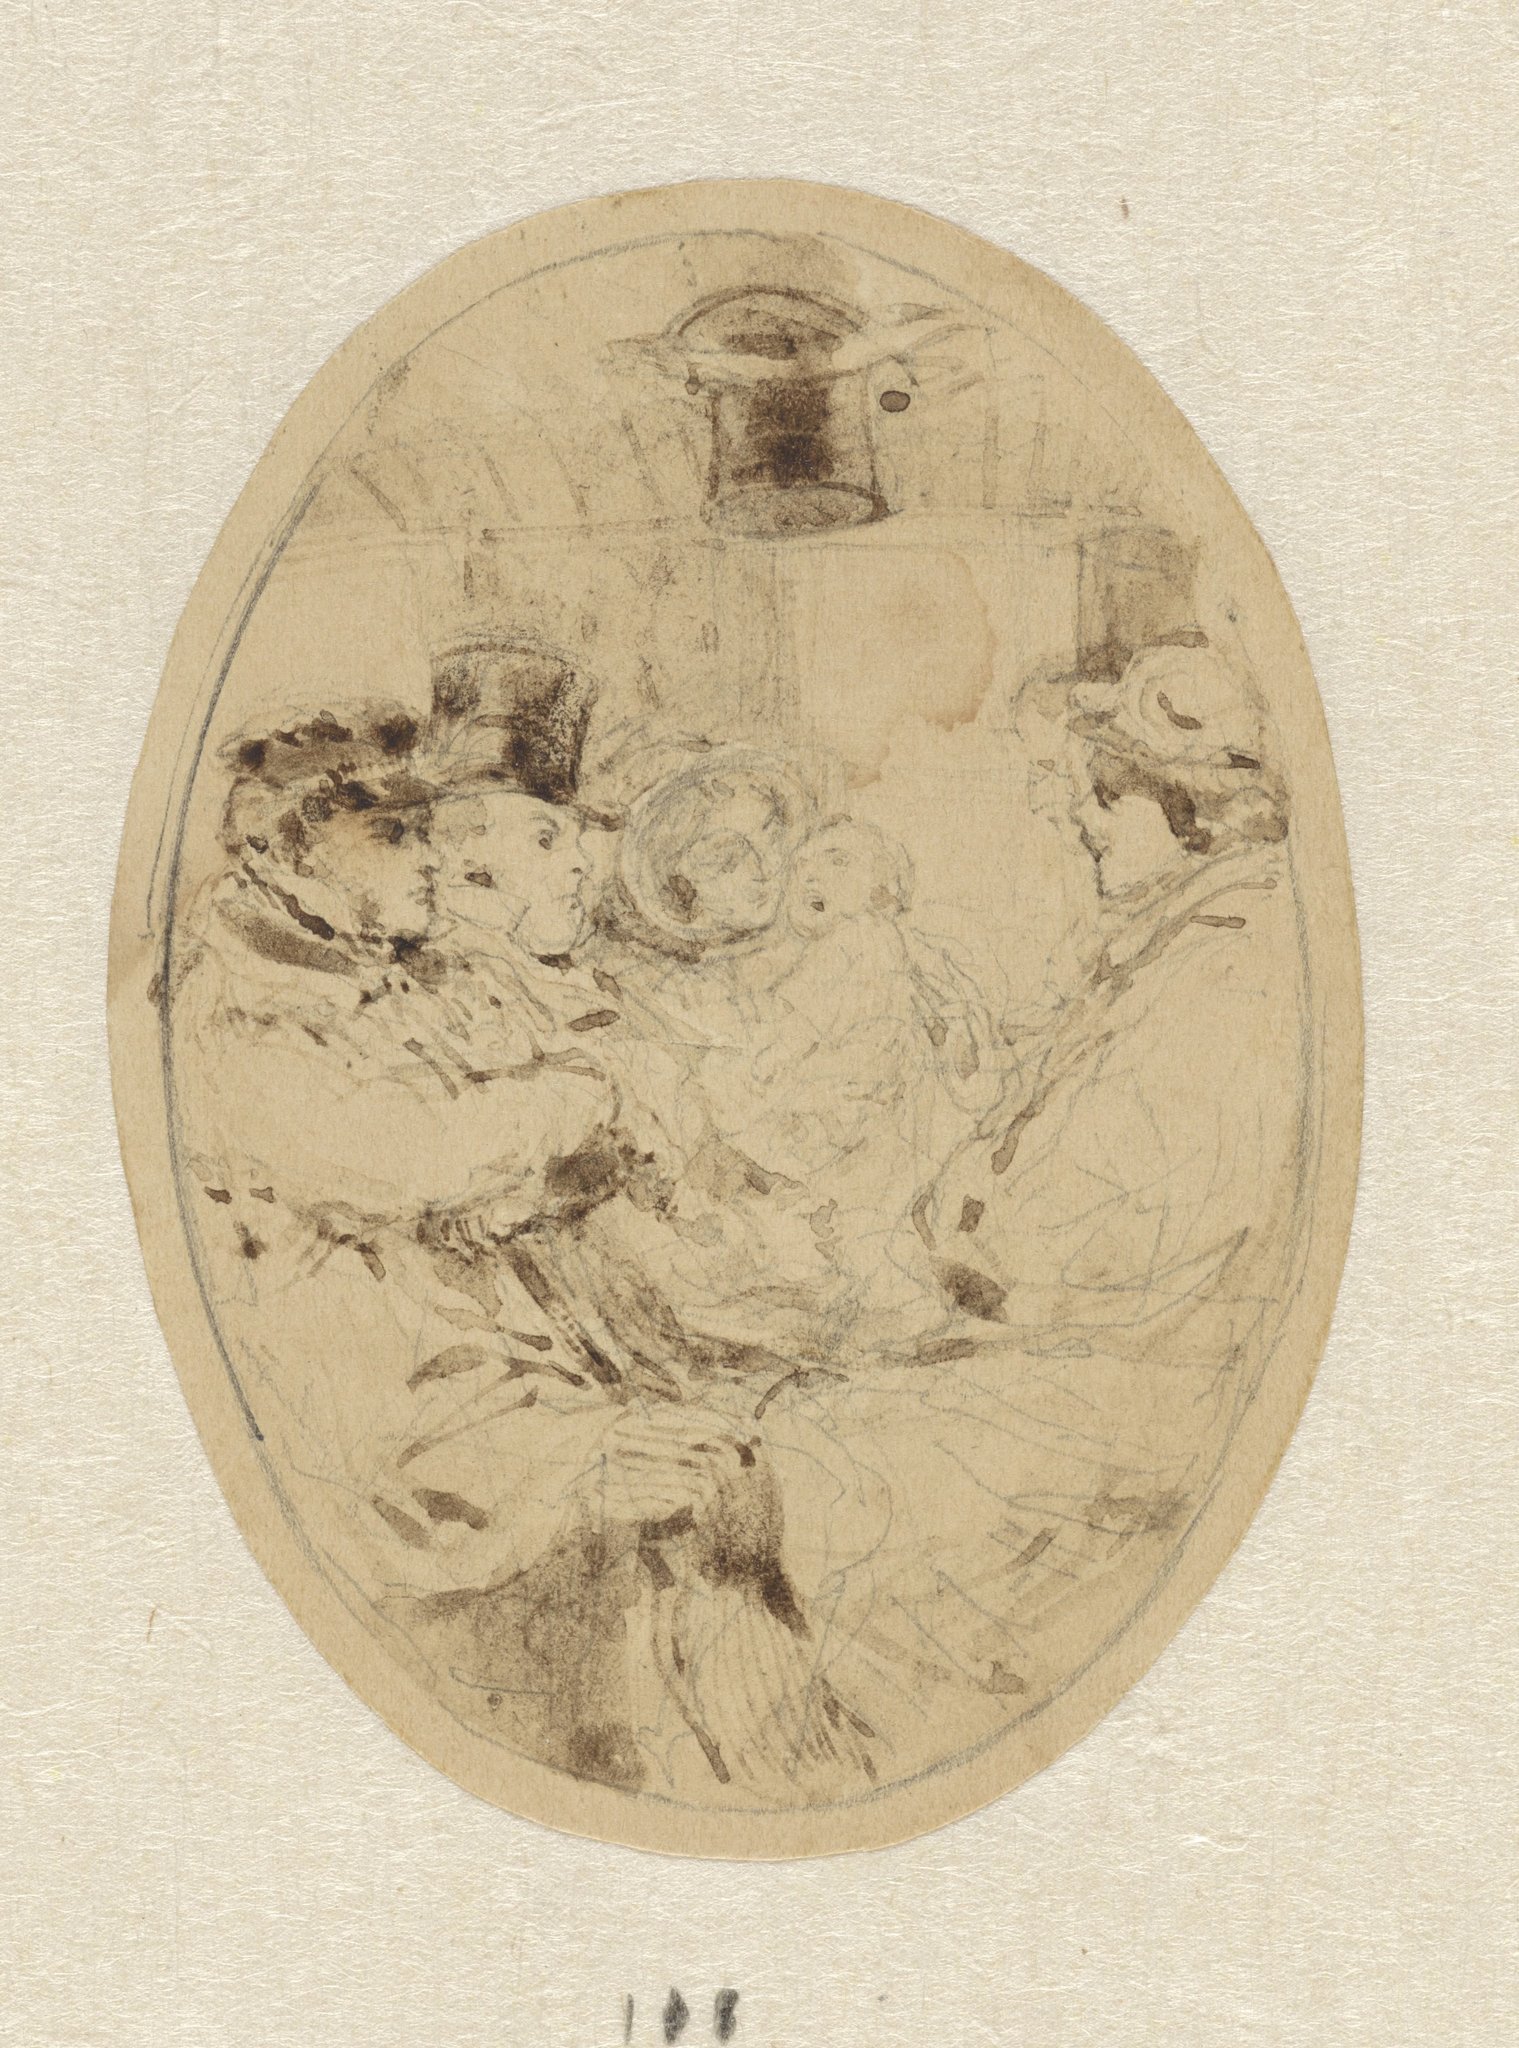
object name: drawing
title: Gezelschap in een coupé, hoge hoed in de lucht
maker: herman frederik carel ten kate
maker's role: draughtsman, painter, print maker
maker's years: 1822-1891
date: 1832-1891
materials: paper, pencil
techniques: brush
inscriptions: inscription: ‘I’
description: Boekillustratie voor roman uitgegeven door A.C. Kruseman te Haarlem, no.I (?)